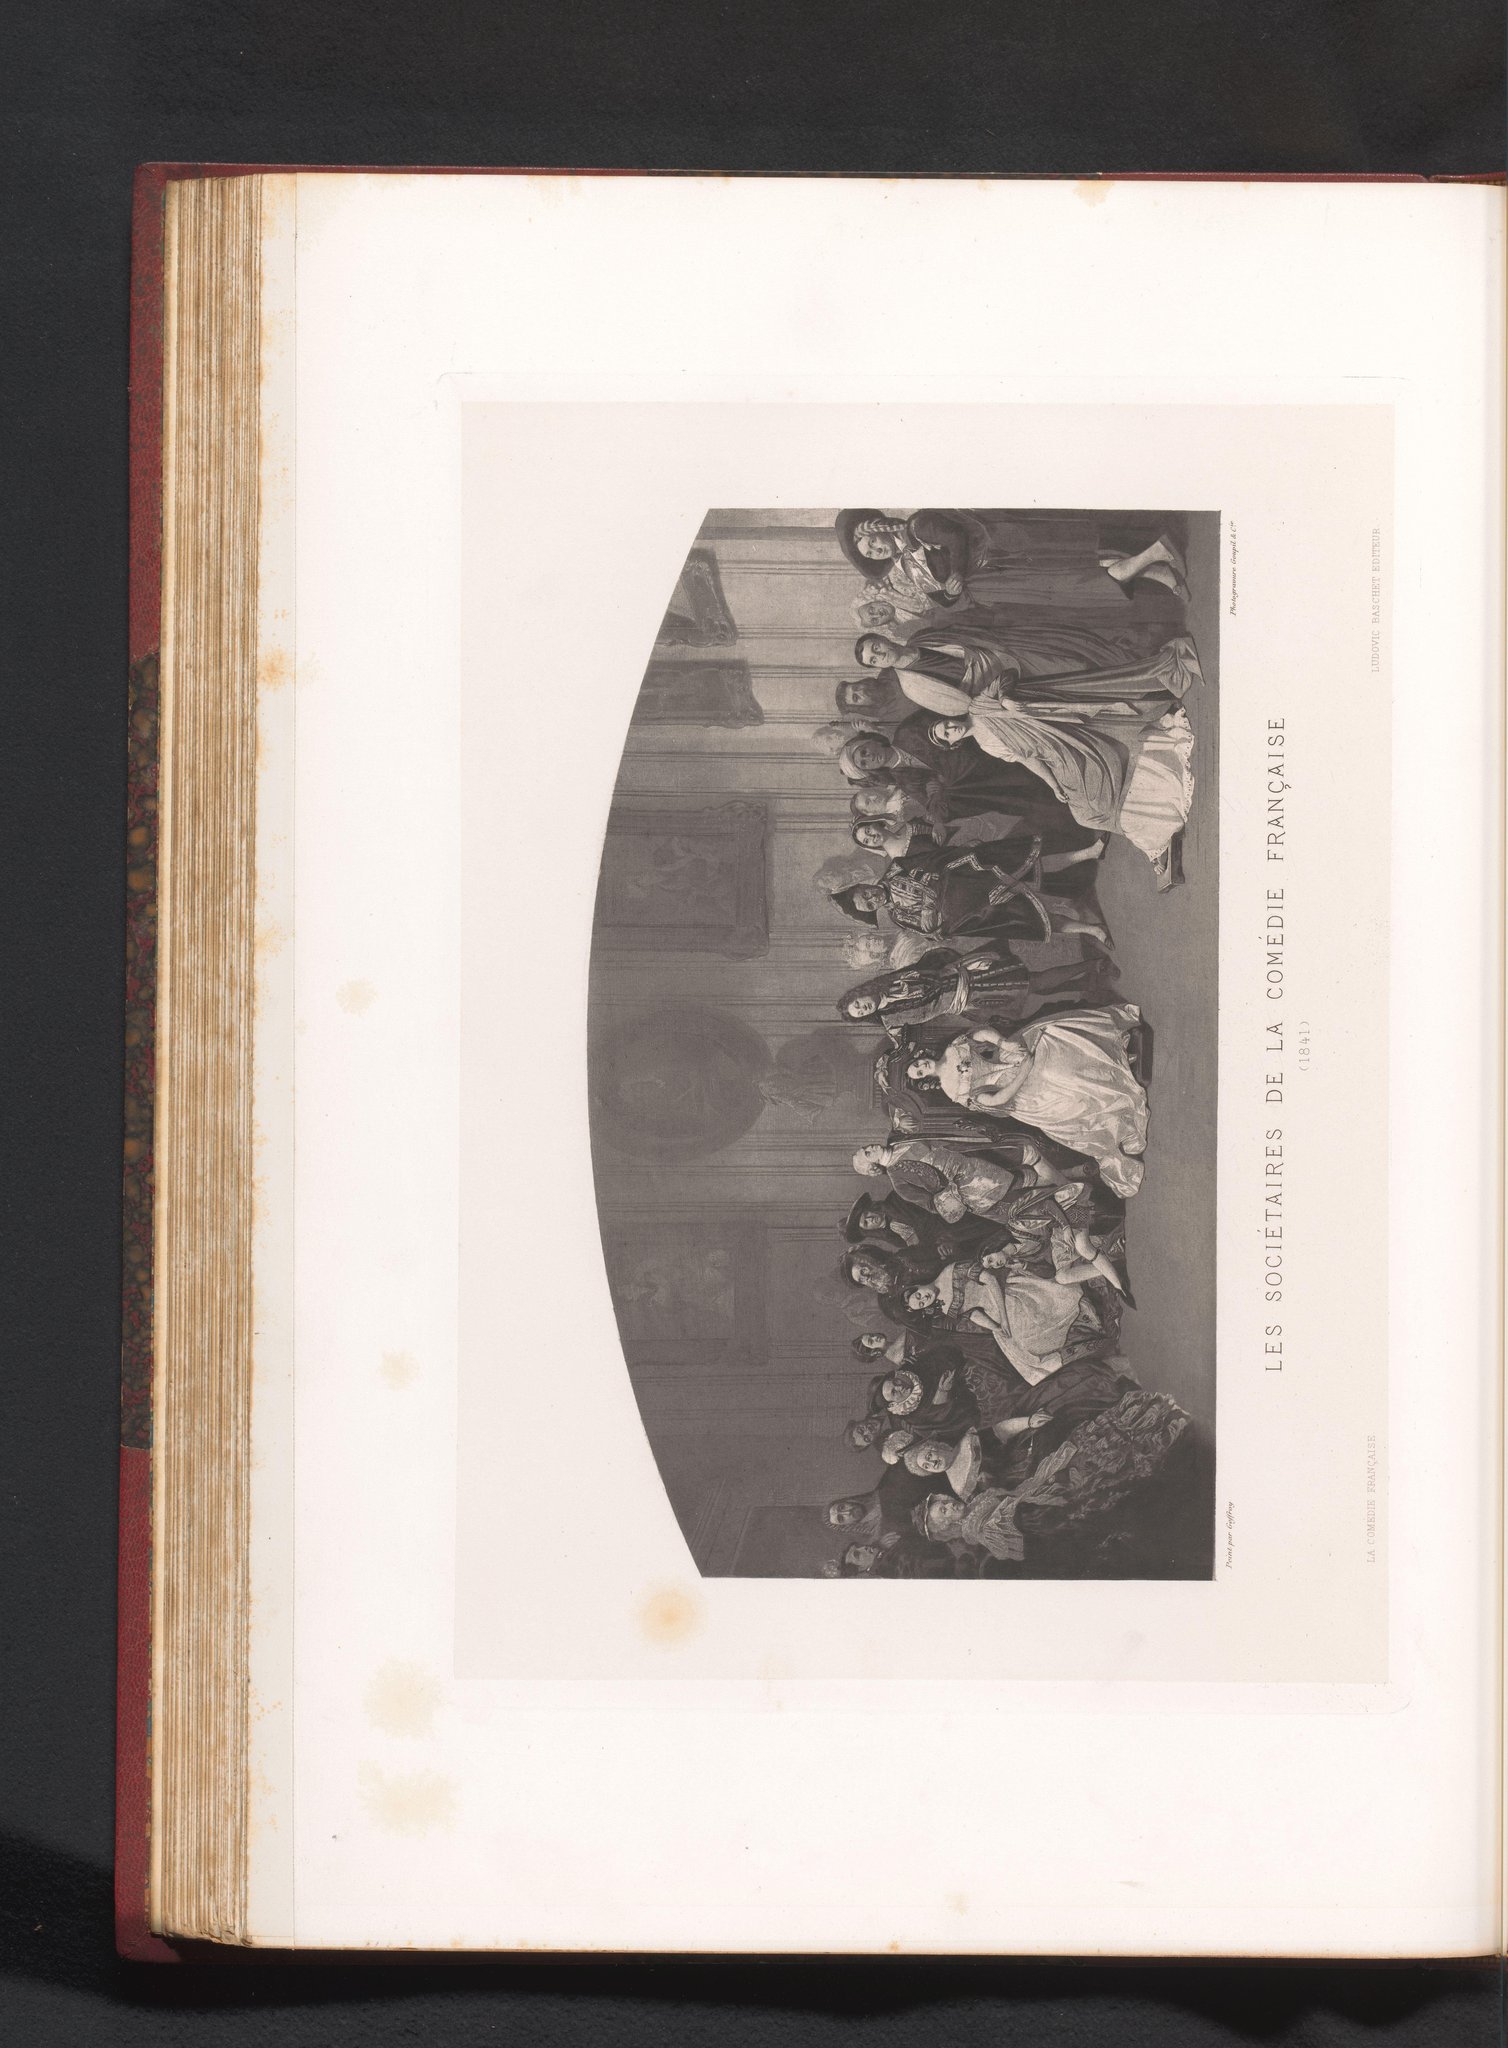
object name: page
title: Les Sociétaires de la Comédie Française (1841)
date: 1875-1880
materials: paper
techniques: photoaquatint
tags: paris, draughtsman, designer, gustave geffroy, portrait of actor, actress, anonymous historical persons portrayed in a group, in a group-portrait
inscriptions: inscription: ‘LA COMÉDIE FRANÇAISE’